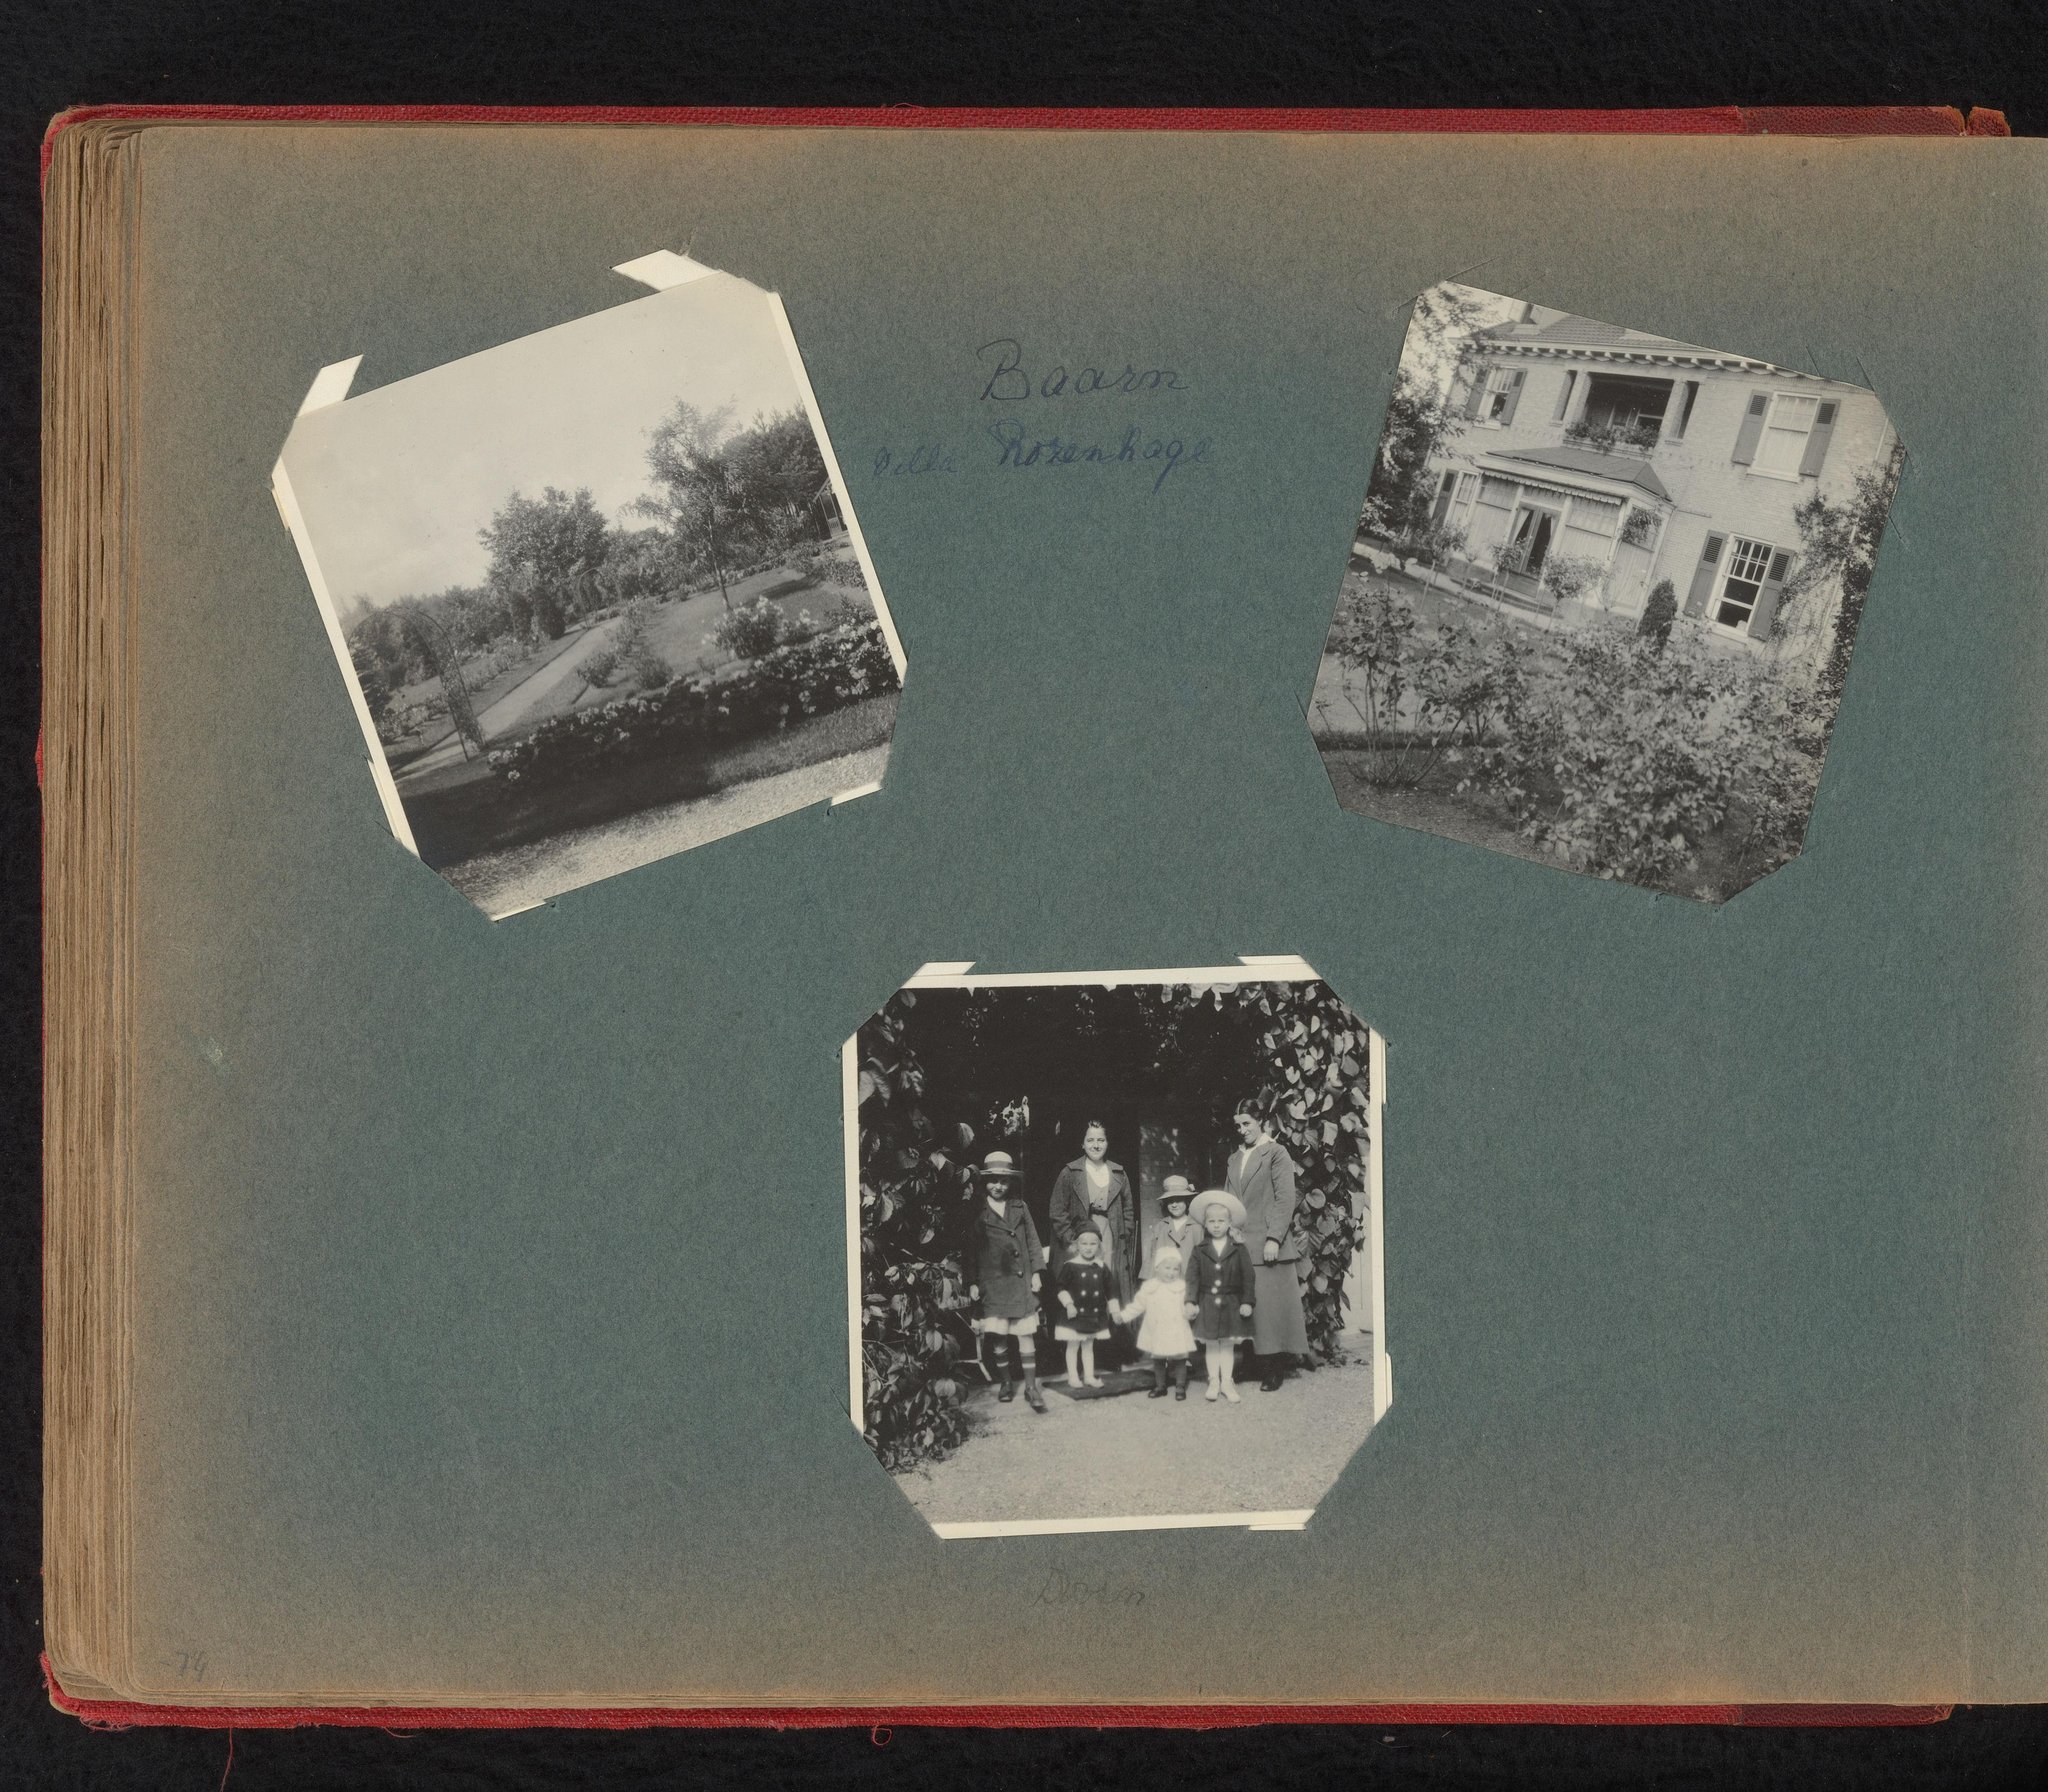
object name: album leaf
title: Gezicht op Villa Rozenhage in Baarn en een groepsportret met vijf onbekende kinderen en twee vrouwen in Doorn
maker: charlotte alida boelen-matthes (lot)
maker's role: amateurfotograaf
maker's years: 1889-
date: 1917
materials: paper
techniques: gelatin silver print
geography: netherlands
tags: villa, anonymous historical persons portrayed in a group, in a group-portrait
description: Deze foto's zijn onderdeel van een album.